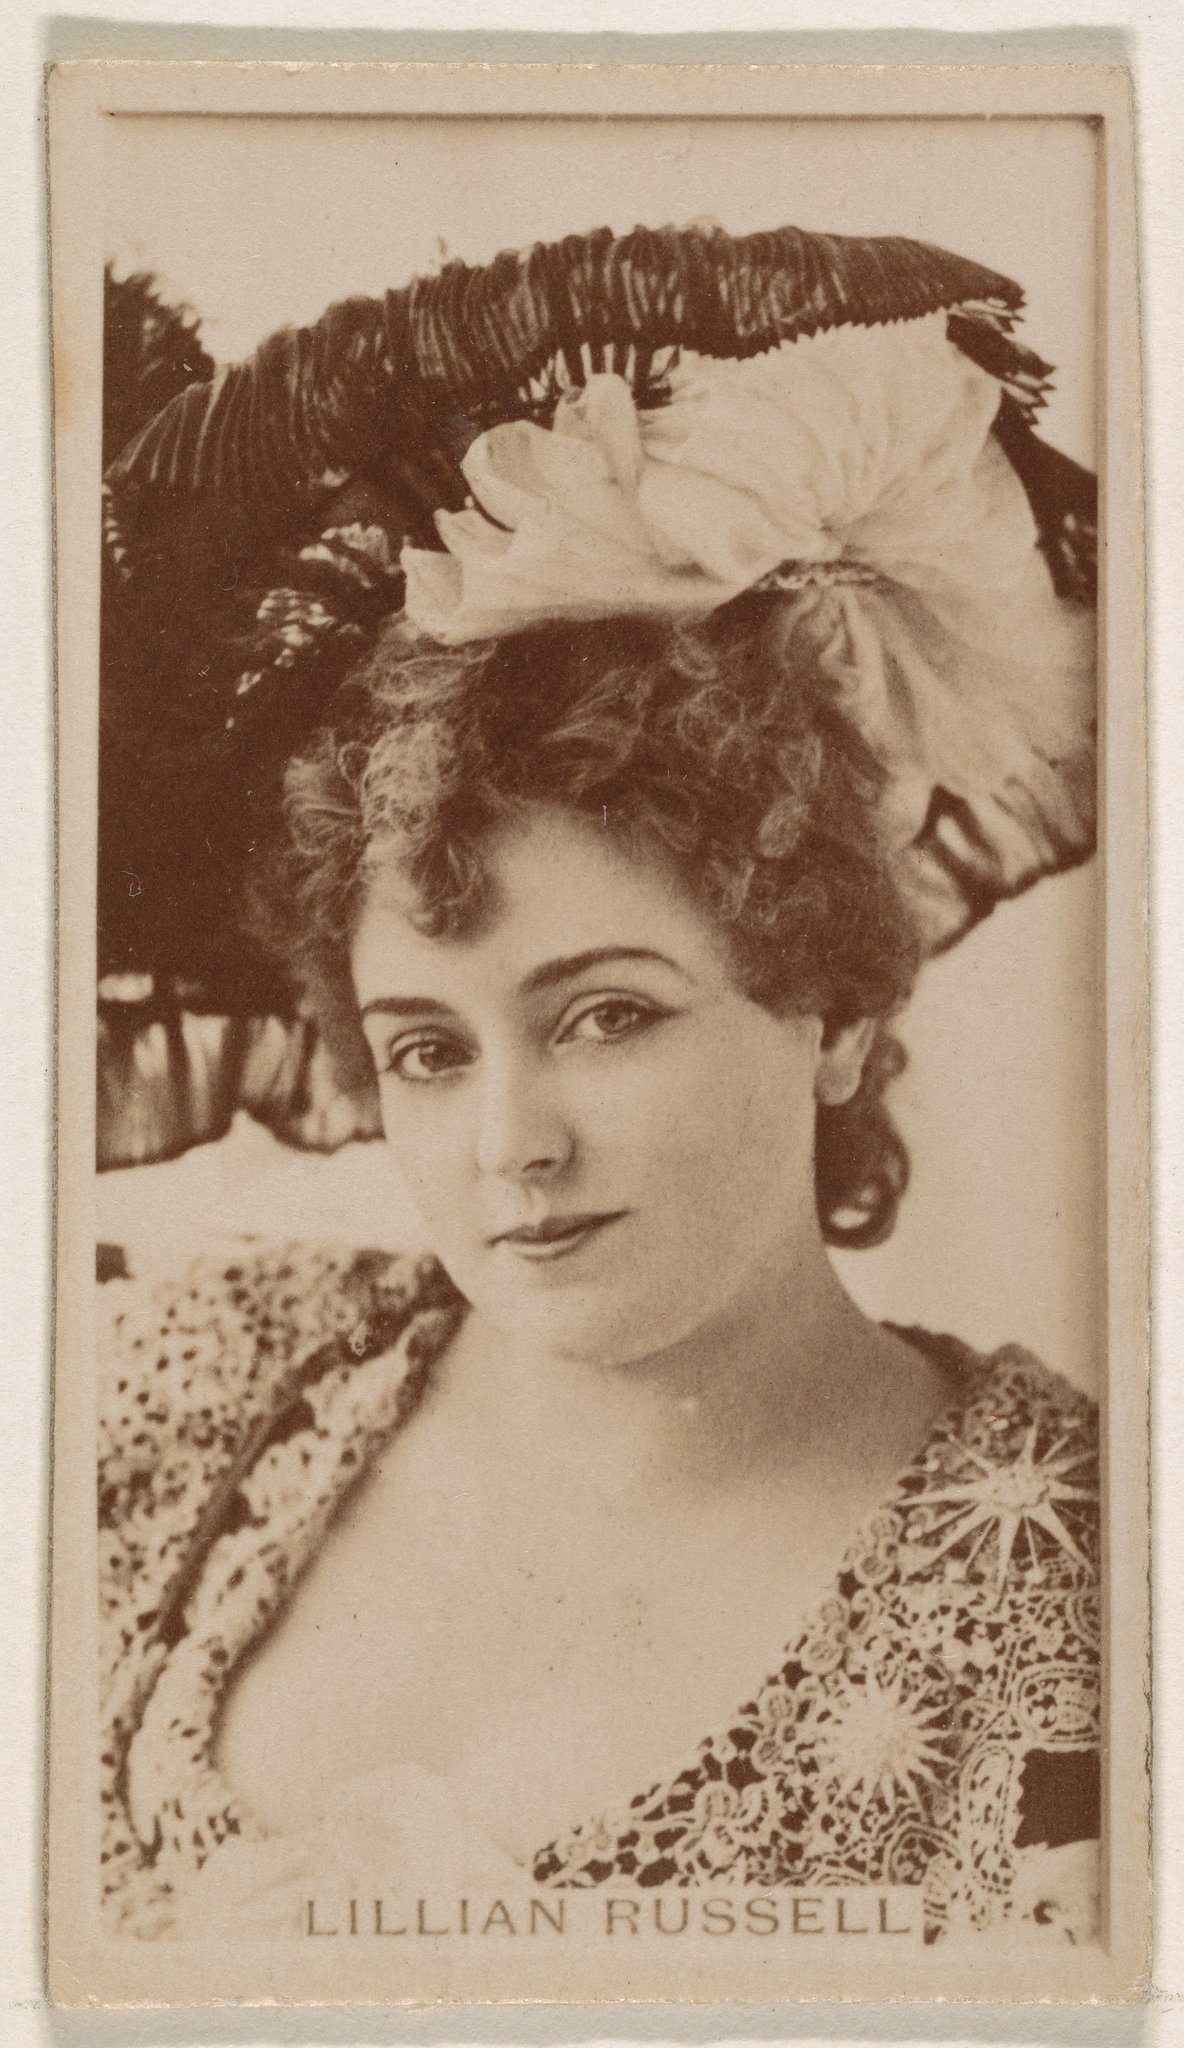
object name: photograph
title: Lillian Russell, from the Actresses series (N245) issued by Kinney Brothers to promote Sweet Caporal Cigarettes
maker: kinney brothers tobacco company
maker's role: publisher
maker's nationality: american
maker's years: 1869-2011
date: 1890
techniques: albumen silver print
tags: portraits,women,actresses